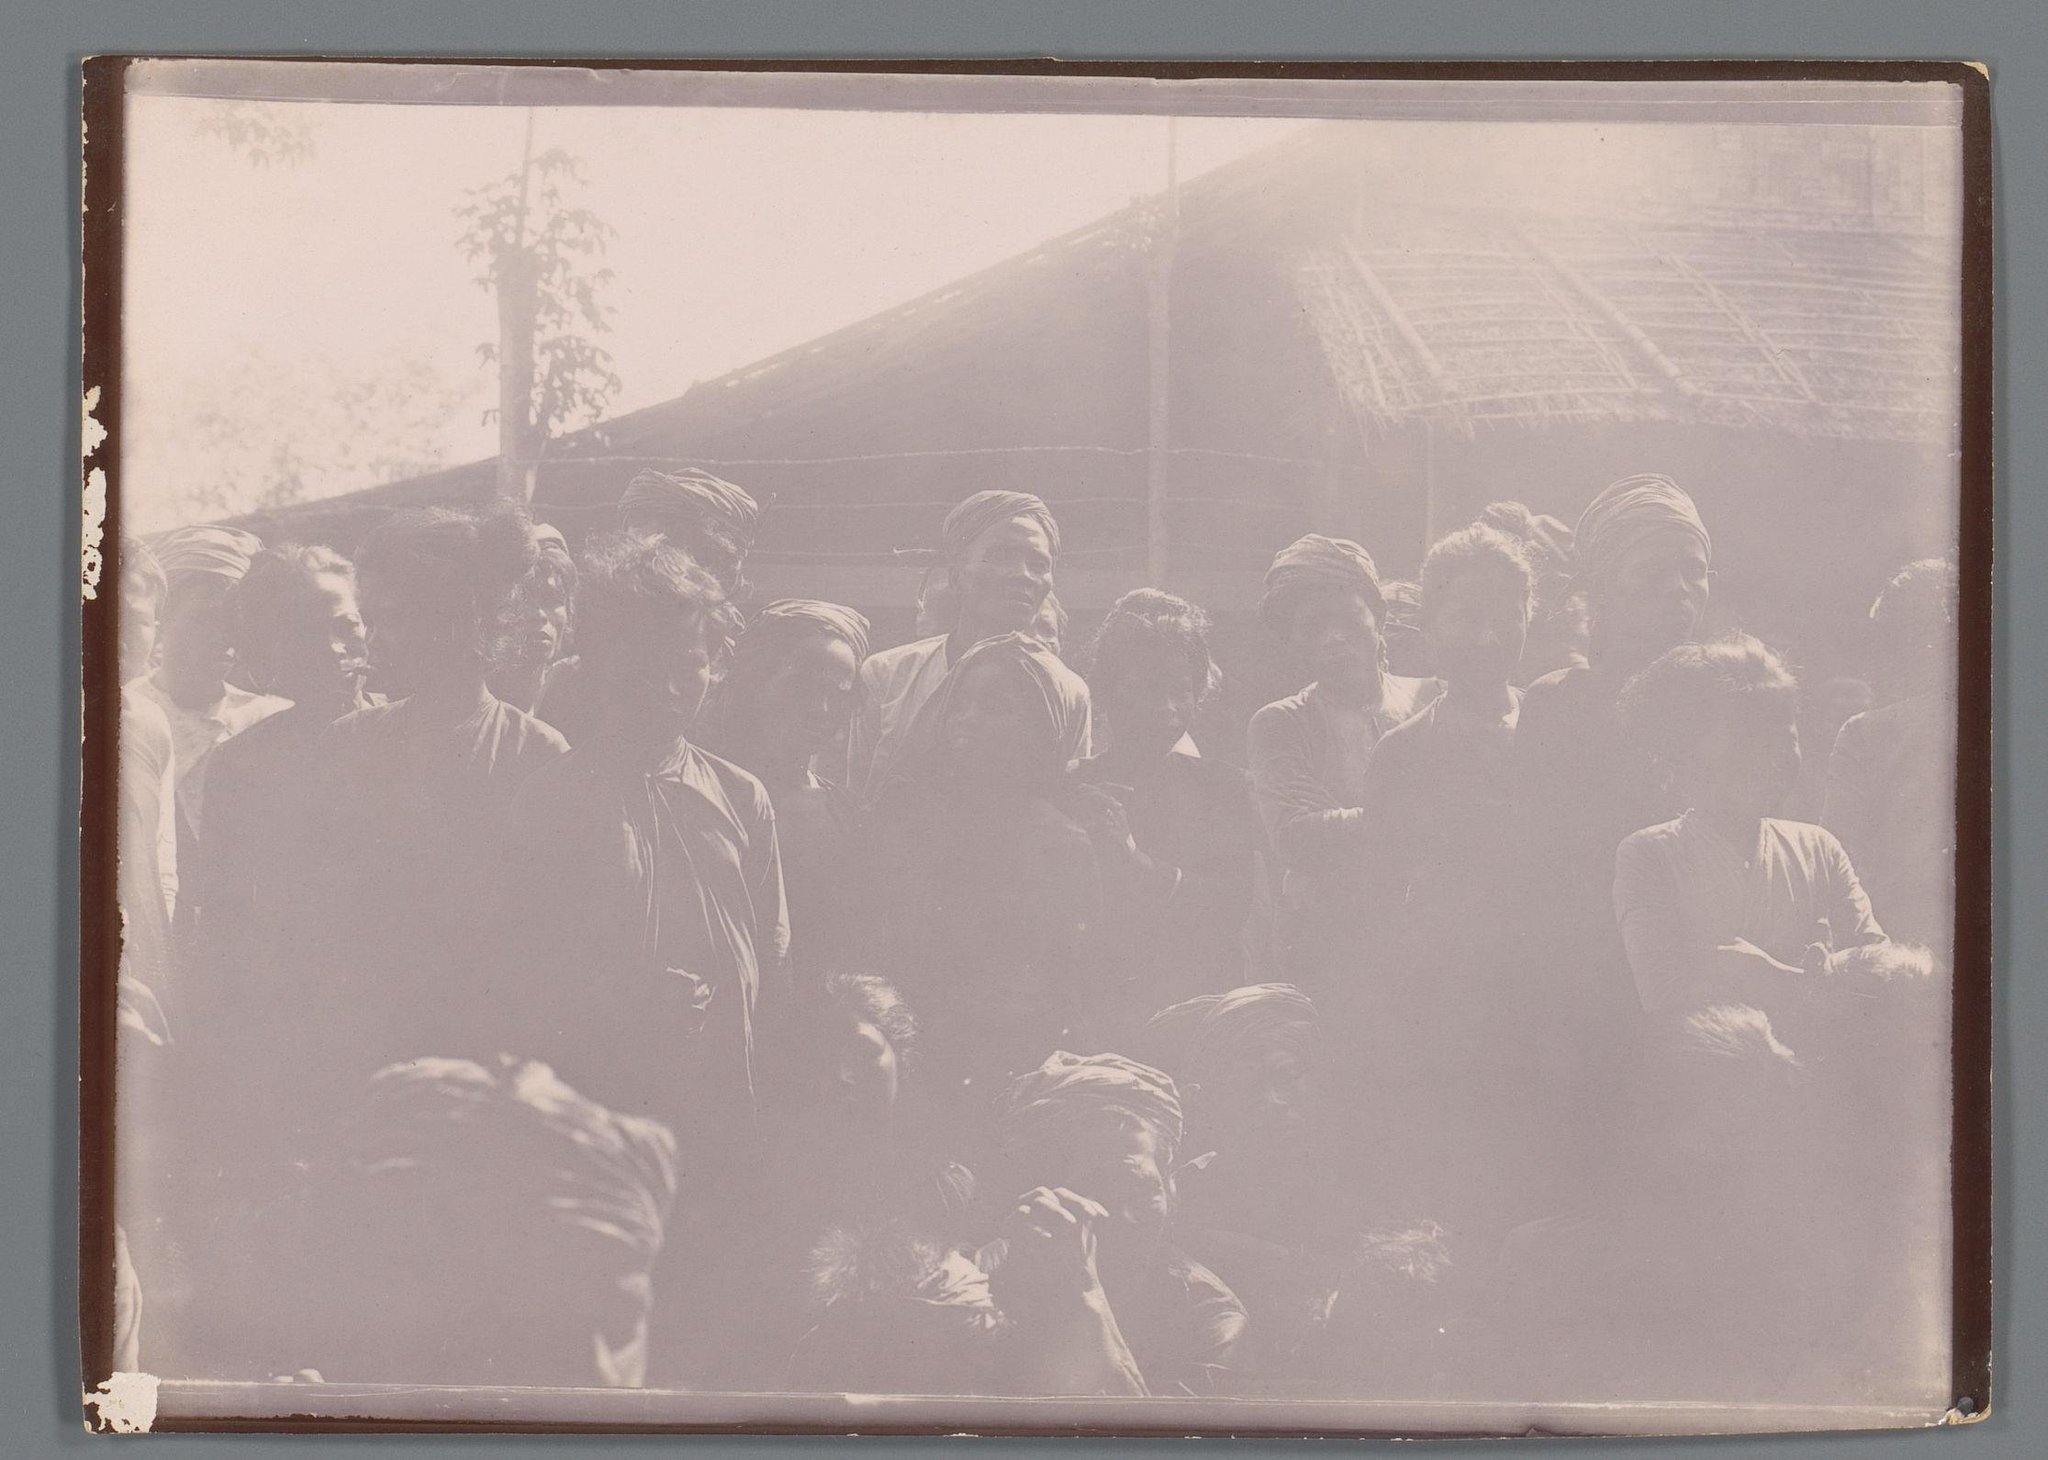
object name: photograph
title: Groep mensen in een dorp, Nederlands-Indië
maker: Anonymous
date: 1880-1910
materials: paper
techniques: collodion silver print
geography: dutch east indies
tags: anonymous historical persons portrayed in a group, in a group-portrait, dutch east indies, the